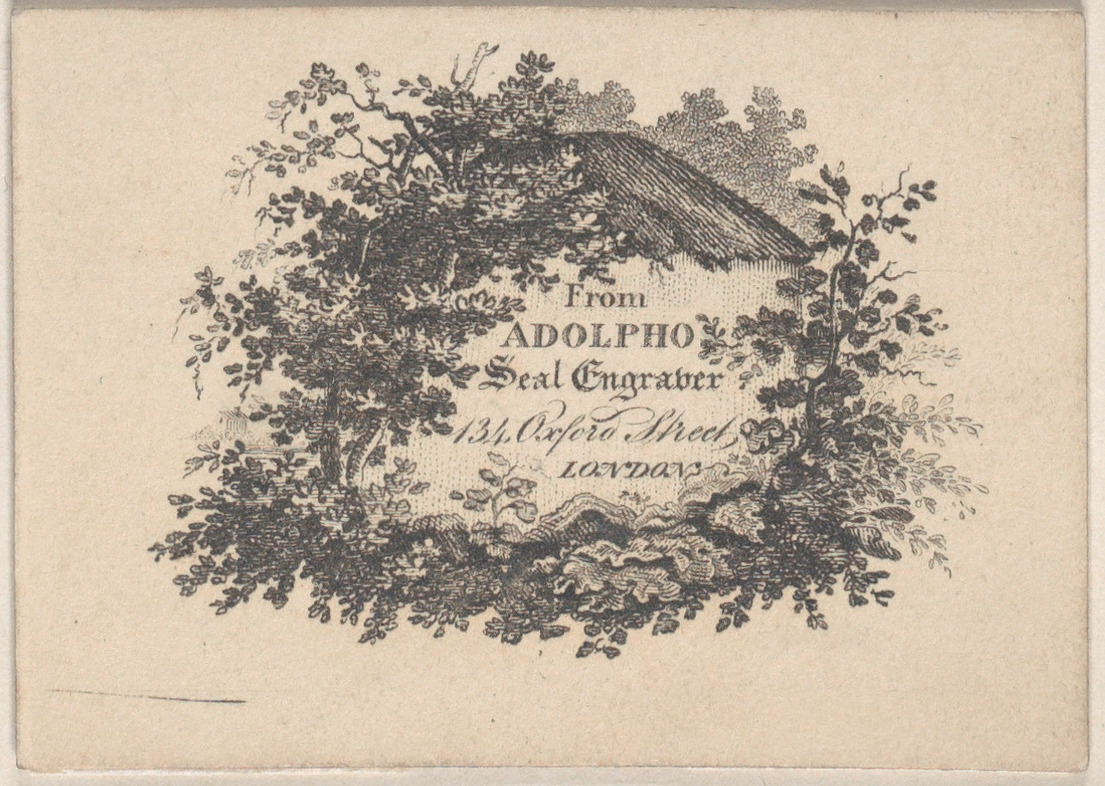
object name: print, trade card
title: Trade Card for Adolpho, Seal Engraver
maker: anonymous, british, 18th century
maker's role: artist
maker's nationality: british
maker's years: 1700-1800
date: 1701-1800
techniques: engraving